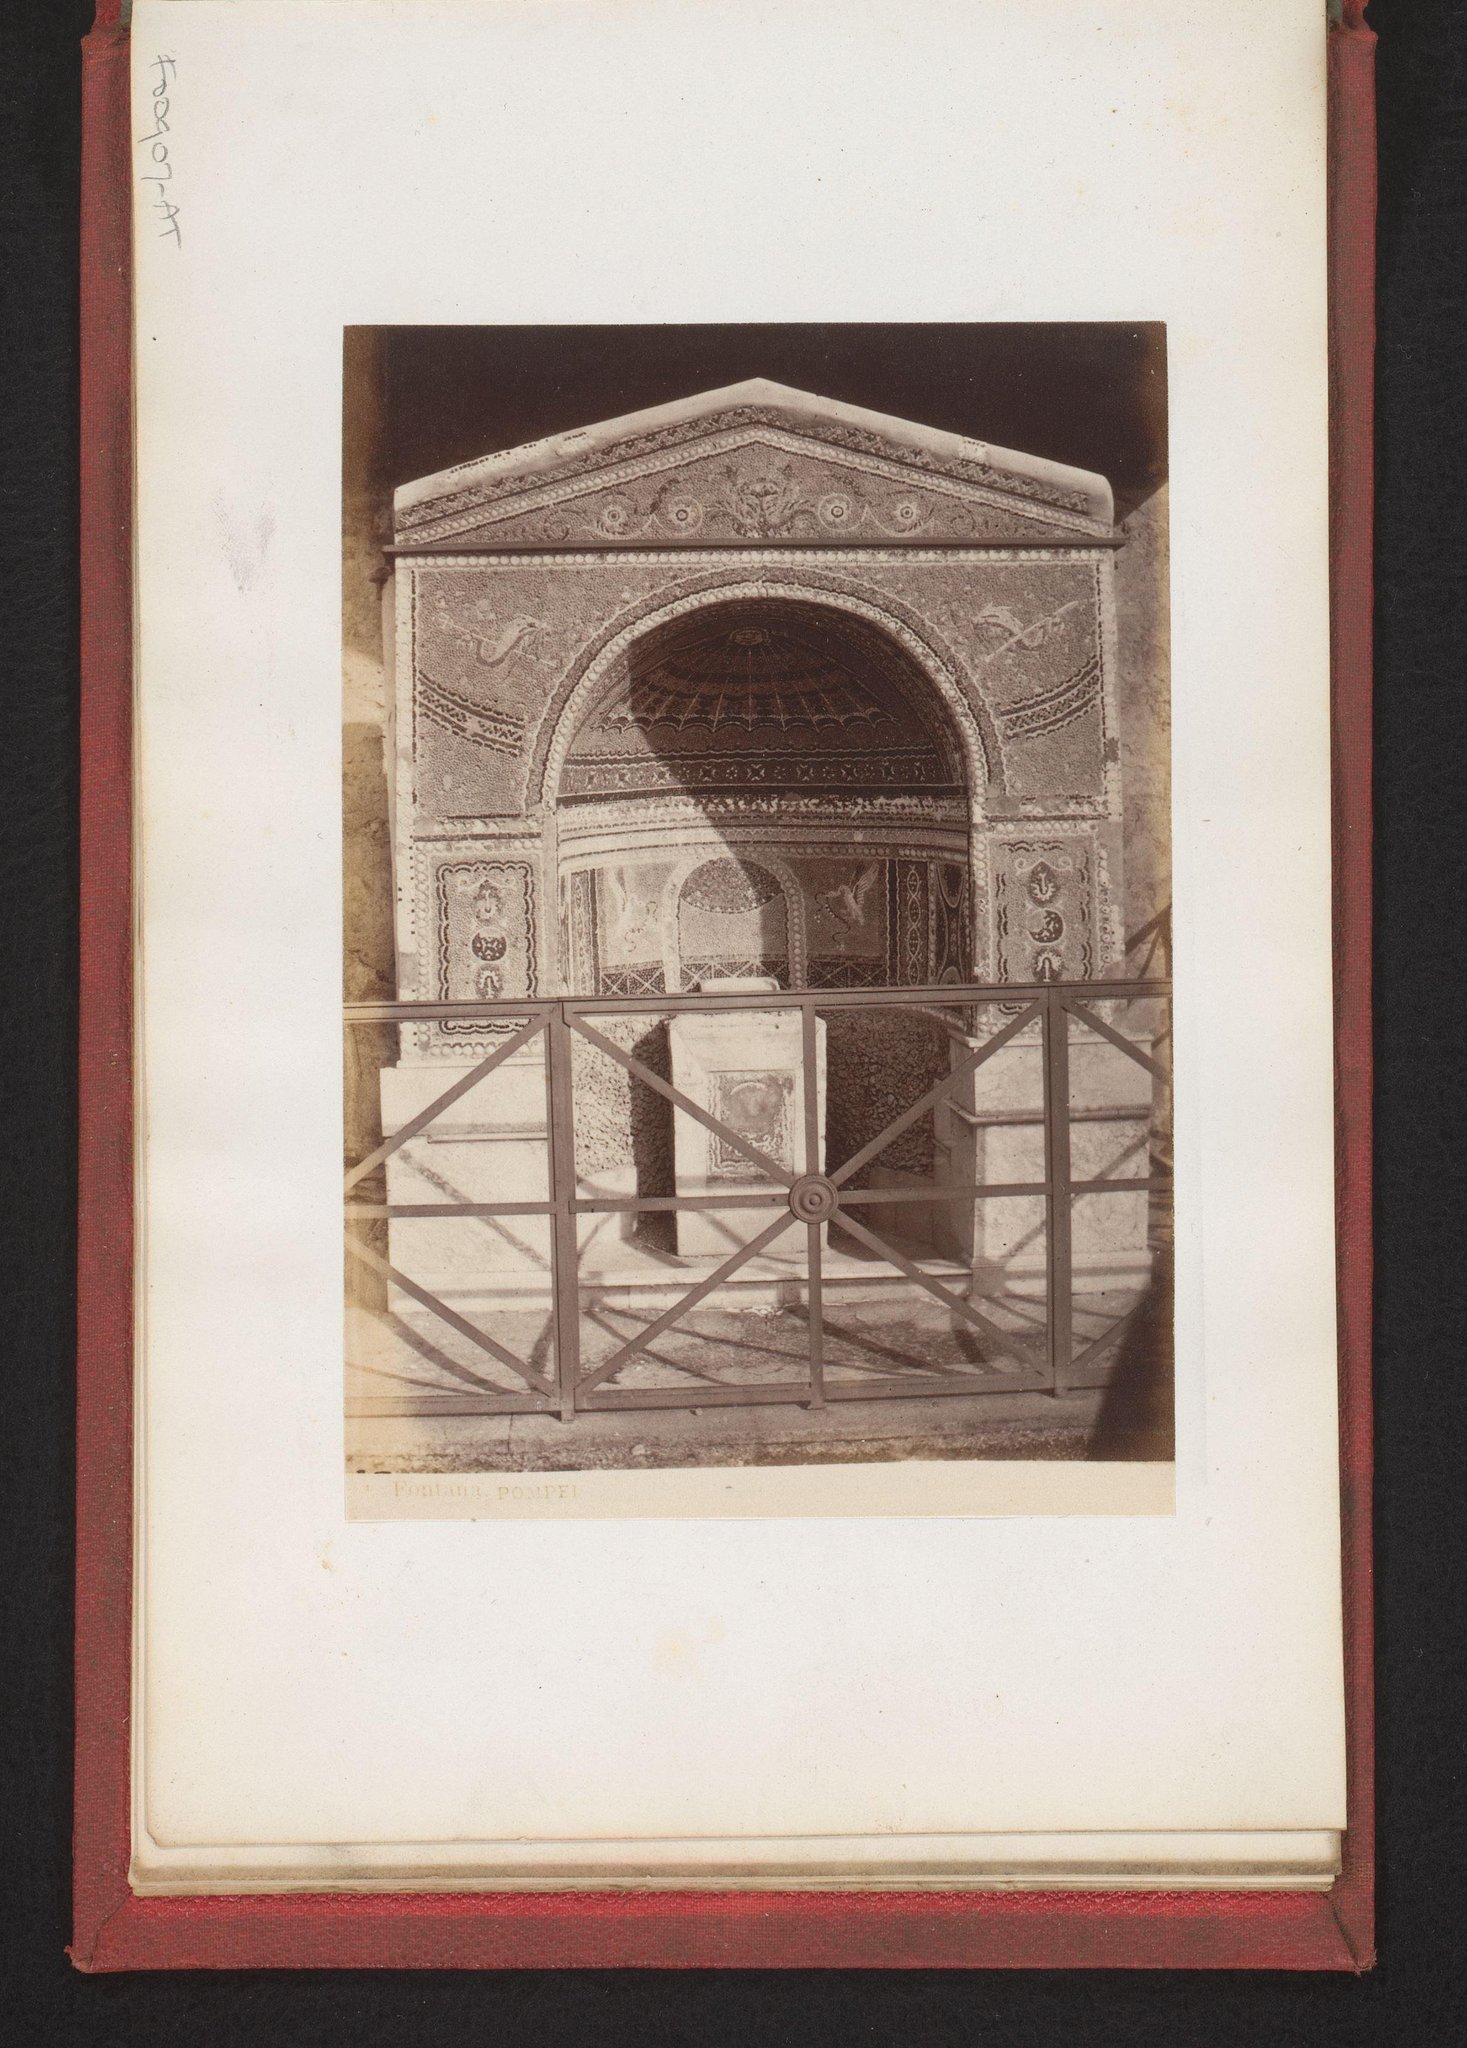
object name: album leaf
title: Fontana Pompei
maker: Anonymous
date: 1860-1900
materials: photographic support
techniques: albumen print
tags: ornamental fountain, pompeii